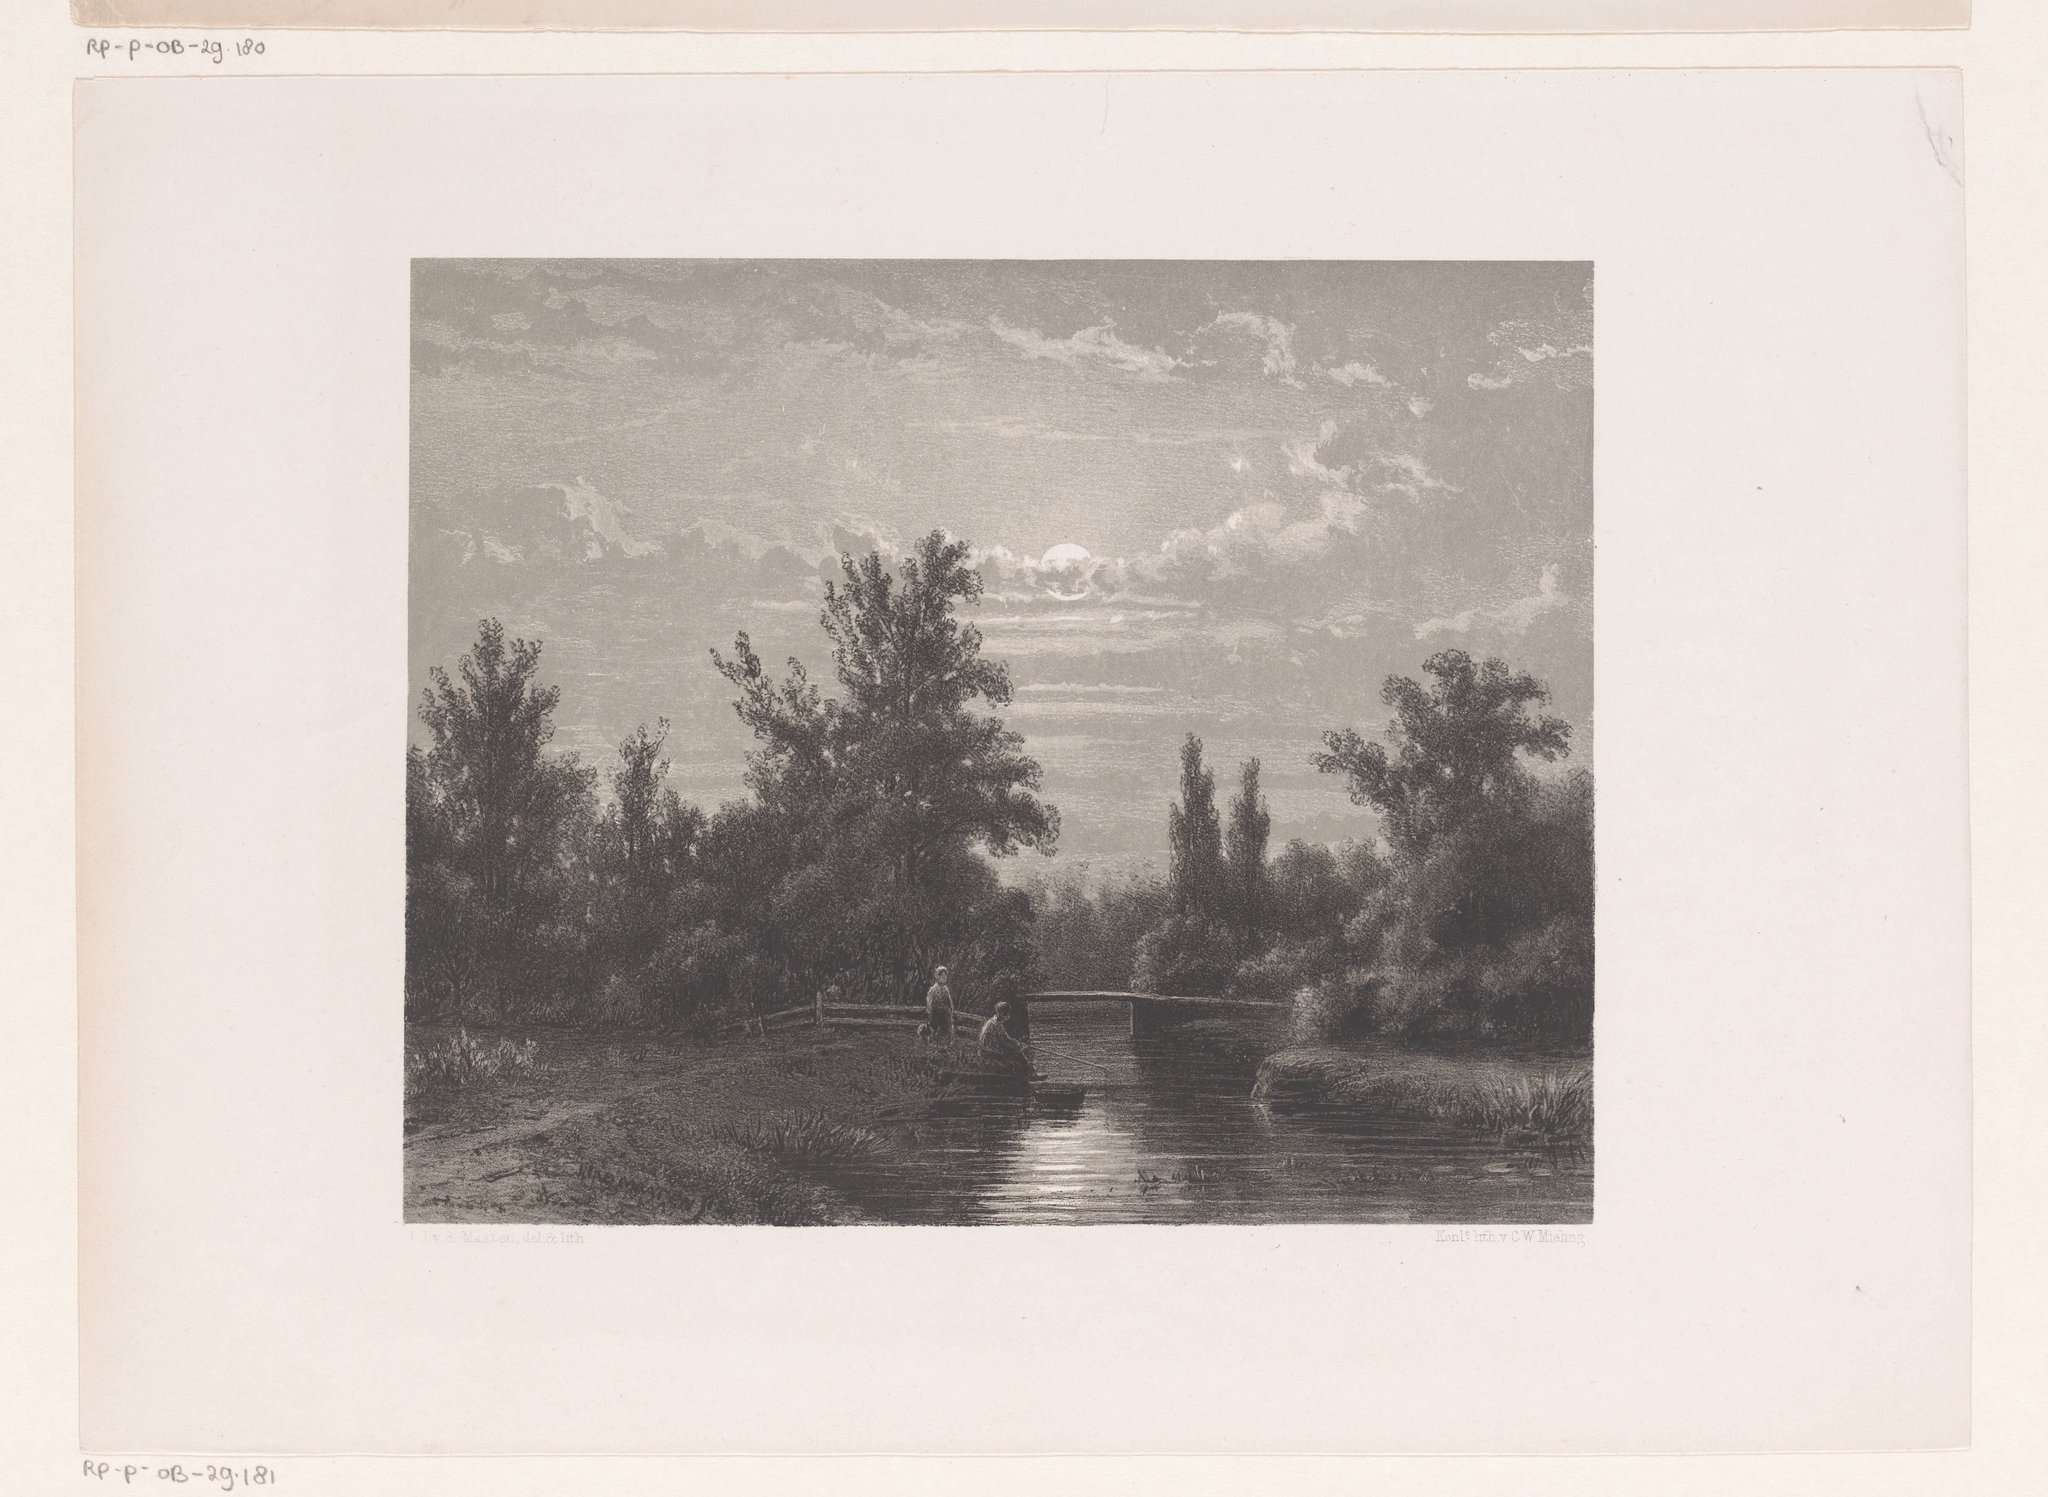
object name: print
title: Vissers bij rivier bij volle maan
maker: jacob jan van der maaten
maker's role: draughtsman, print maker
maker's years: 1820-1879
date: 1851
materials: paper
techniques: tone lithography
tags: full moon, bridge, river (+ landscape with figures, staffage), fisherman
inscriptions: collector's mark: Lugt 2228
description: Deze prent werd ook als een tafereel in daglicht gedrukt. Zie: RP-P-OB-29.180.